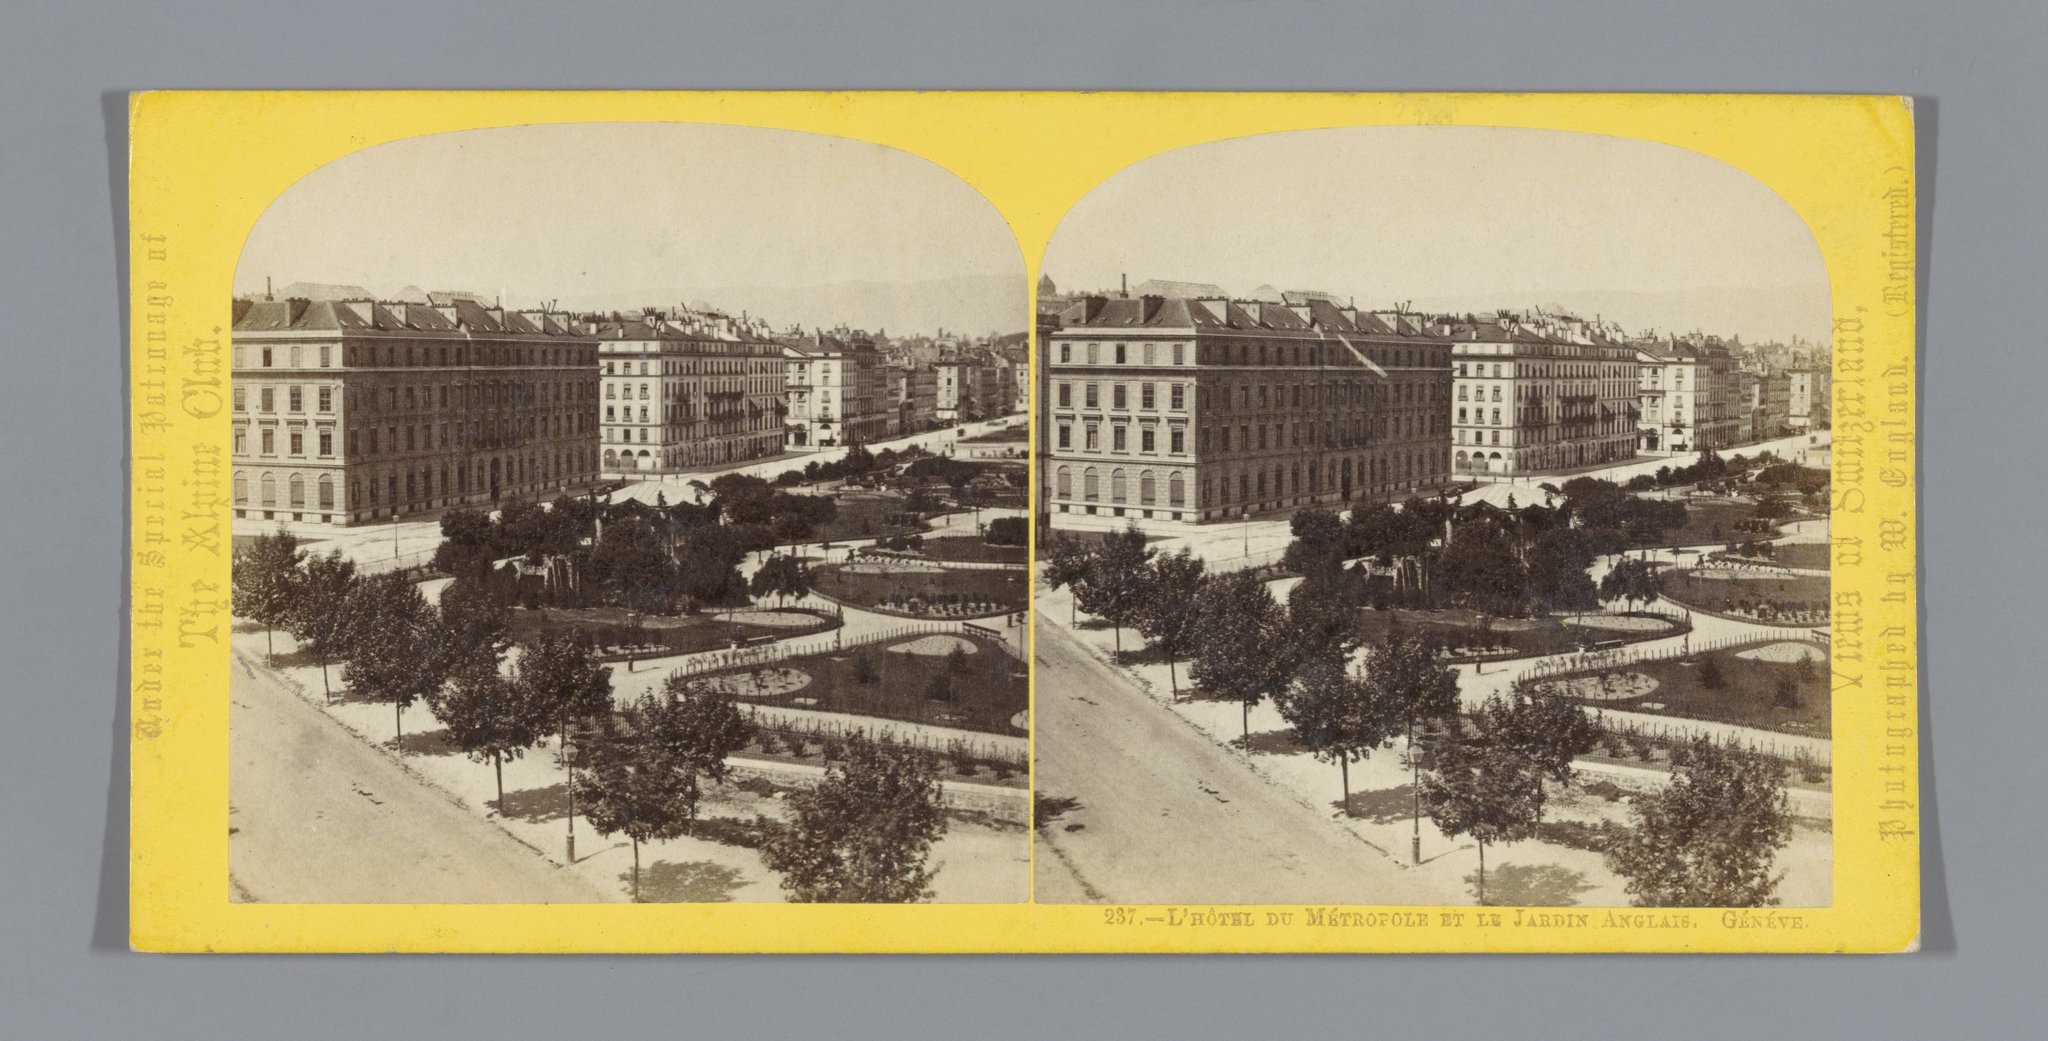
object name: stereograph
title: Gezicht op de Jardin Anglais te Genève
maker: william england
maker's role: fotograaf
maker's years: 1816-1896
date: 1850-1880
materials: cardboard, photographic support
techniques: albumen print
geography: geneva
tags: park, city-view in general; 'veduta'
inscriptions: inscription: ‘Views of Switzerland, photographed by W. England. (Registered) Under the Special Patronage of the Alpine Club.’, number: ‘237.’